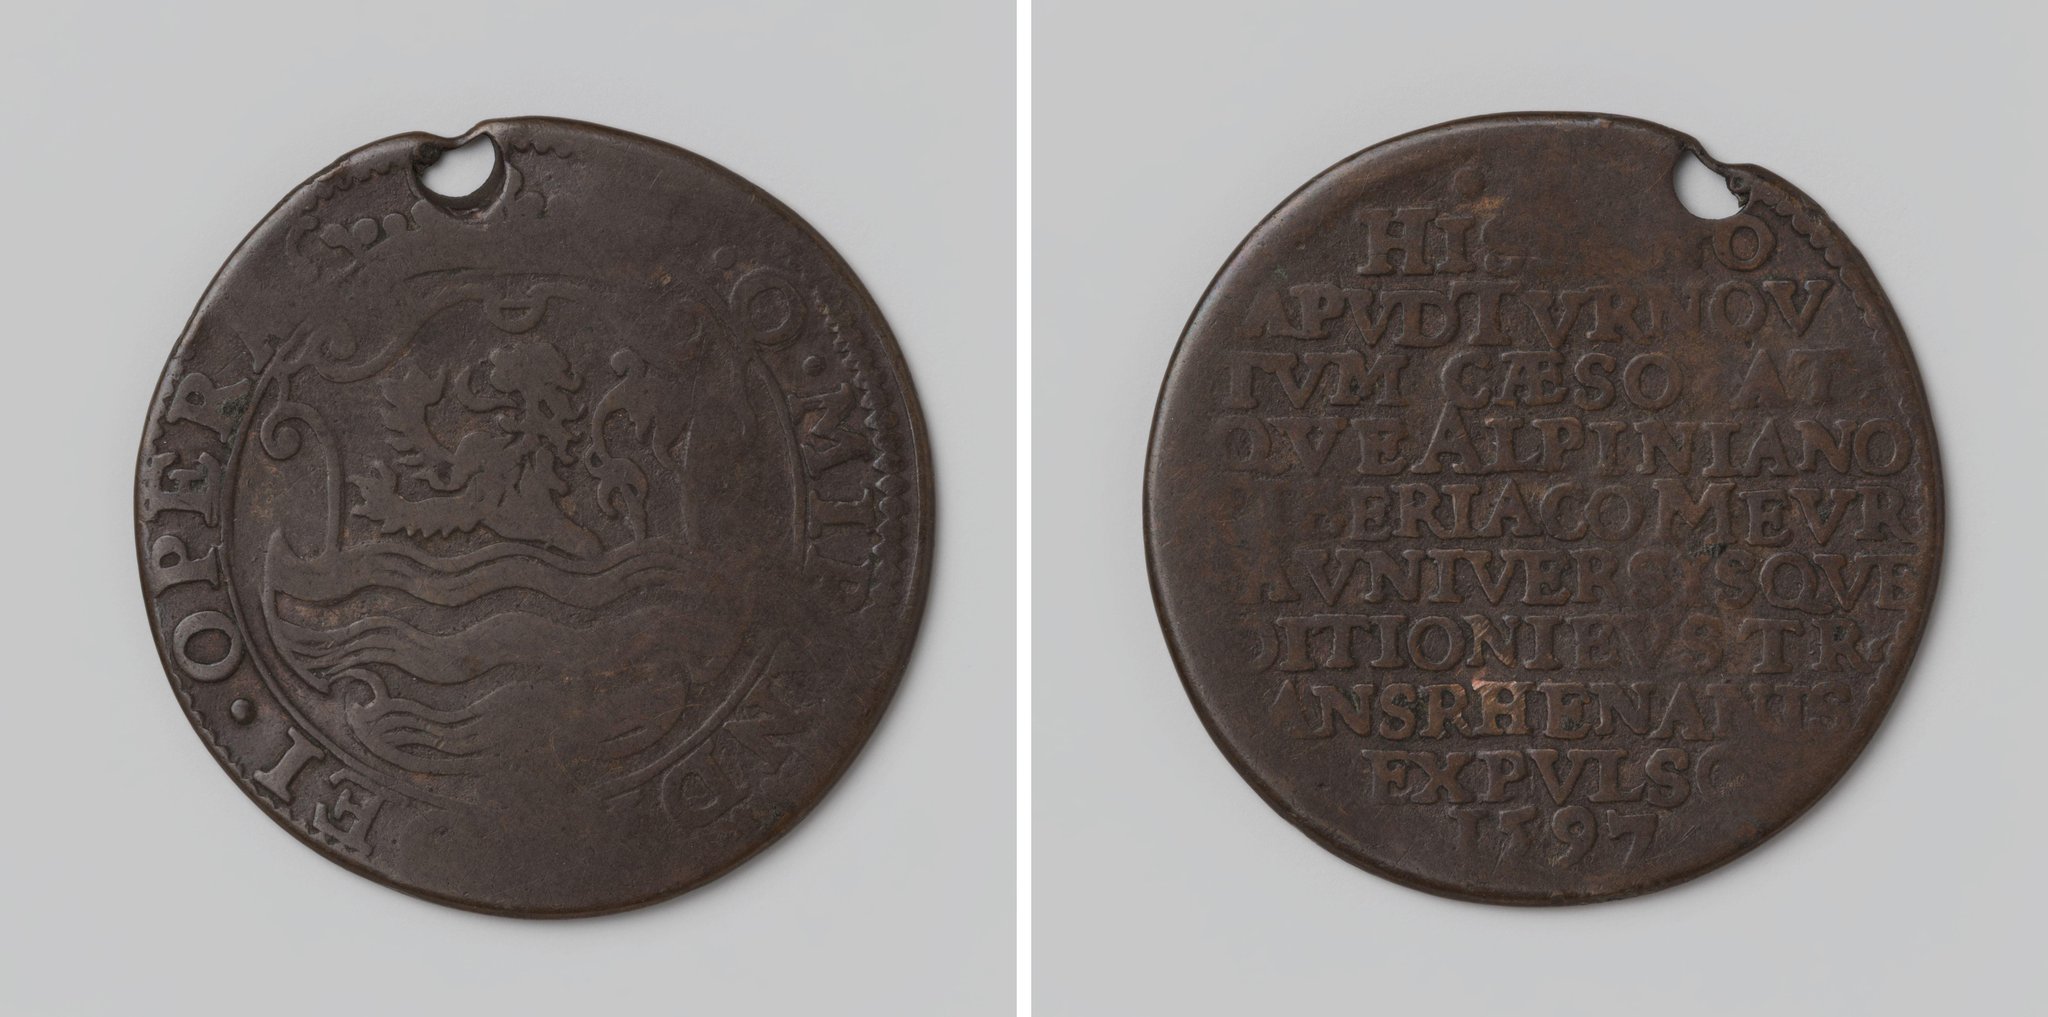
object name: jeton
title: Overwinning in de slag bij Turnhout en het verdrijven van de Spanjaarden uit Alpen, Moers en het Rijngebied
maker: Anonymous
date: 1597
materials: copper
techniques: striking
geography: middelburg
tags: zeeland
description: Koperen penning met gat erin. Voorzijde: gekroond wapenschild in cartouche binnen omschrift. Keerzijde: opschrift